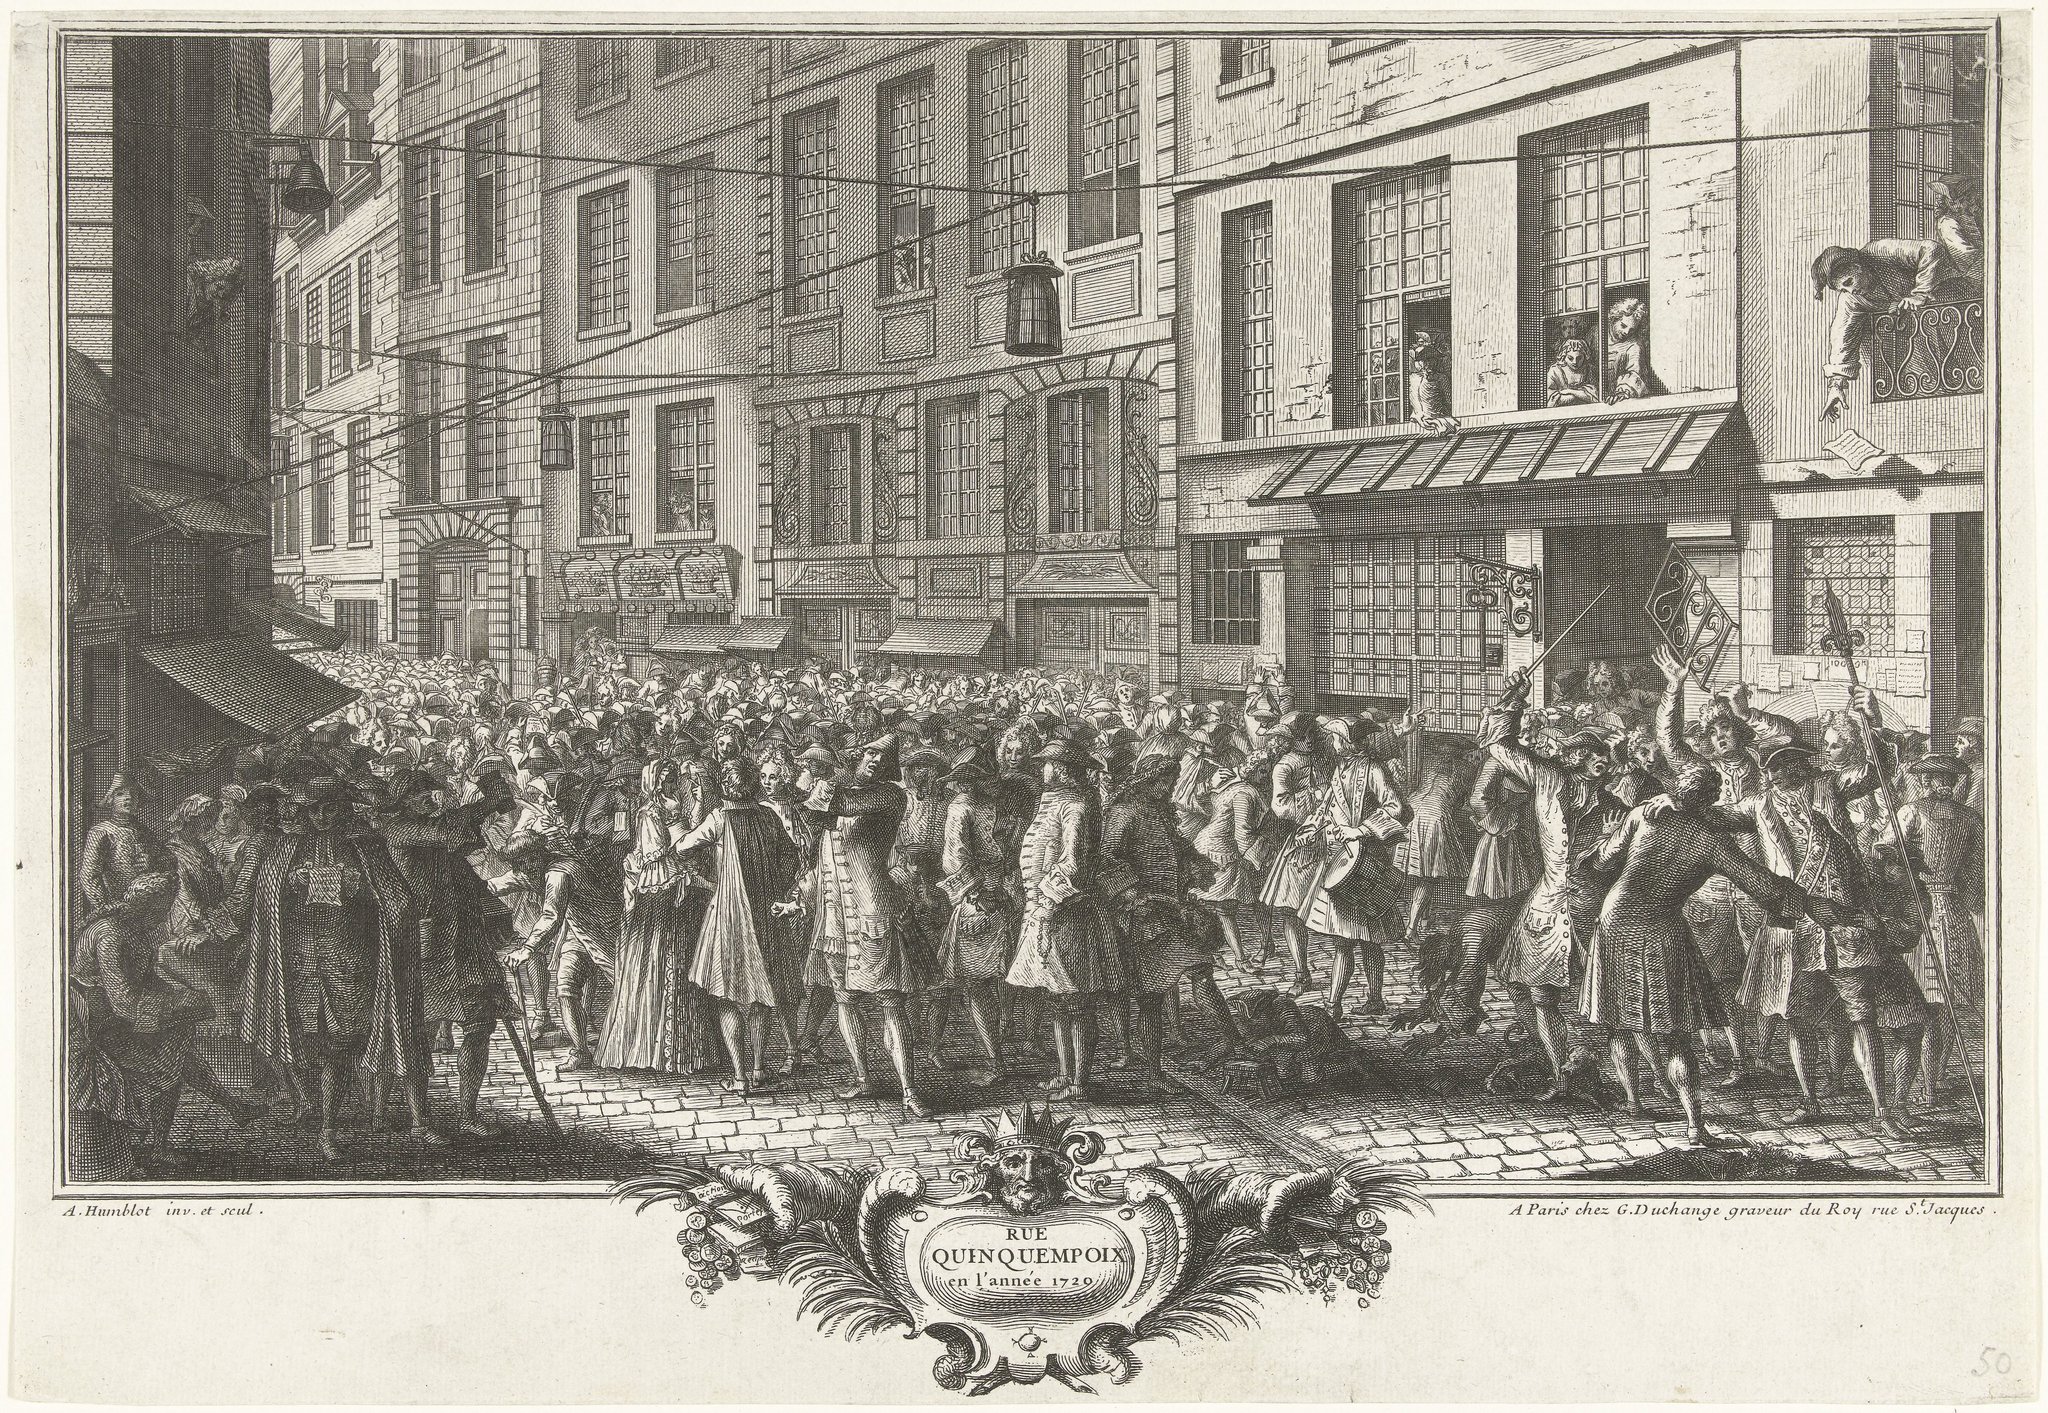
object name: print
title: Het Groote Tafereel der Dwaasheid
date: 1720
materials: paper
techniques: engraving, etching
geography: paris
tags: financial panic, street-fights, riots, paris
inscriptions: collector's mark: Lugt 2228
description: Gezicht in de Rue Quinquempoix te Parijs waar de windhandel voornamelijk gedreven werd. Opstootjes op straat tussen handelaren en geruïneerde kopers. Prent 16 in de serie Het Groote Tafereel der Dwaasheid met spotprenten op de Windhandel of Actiehandel van 1720.